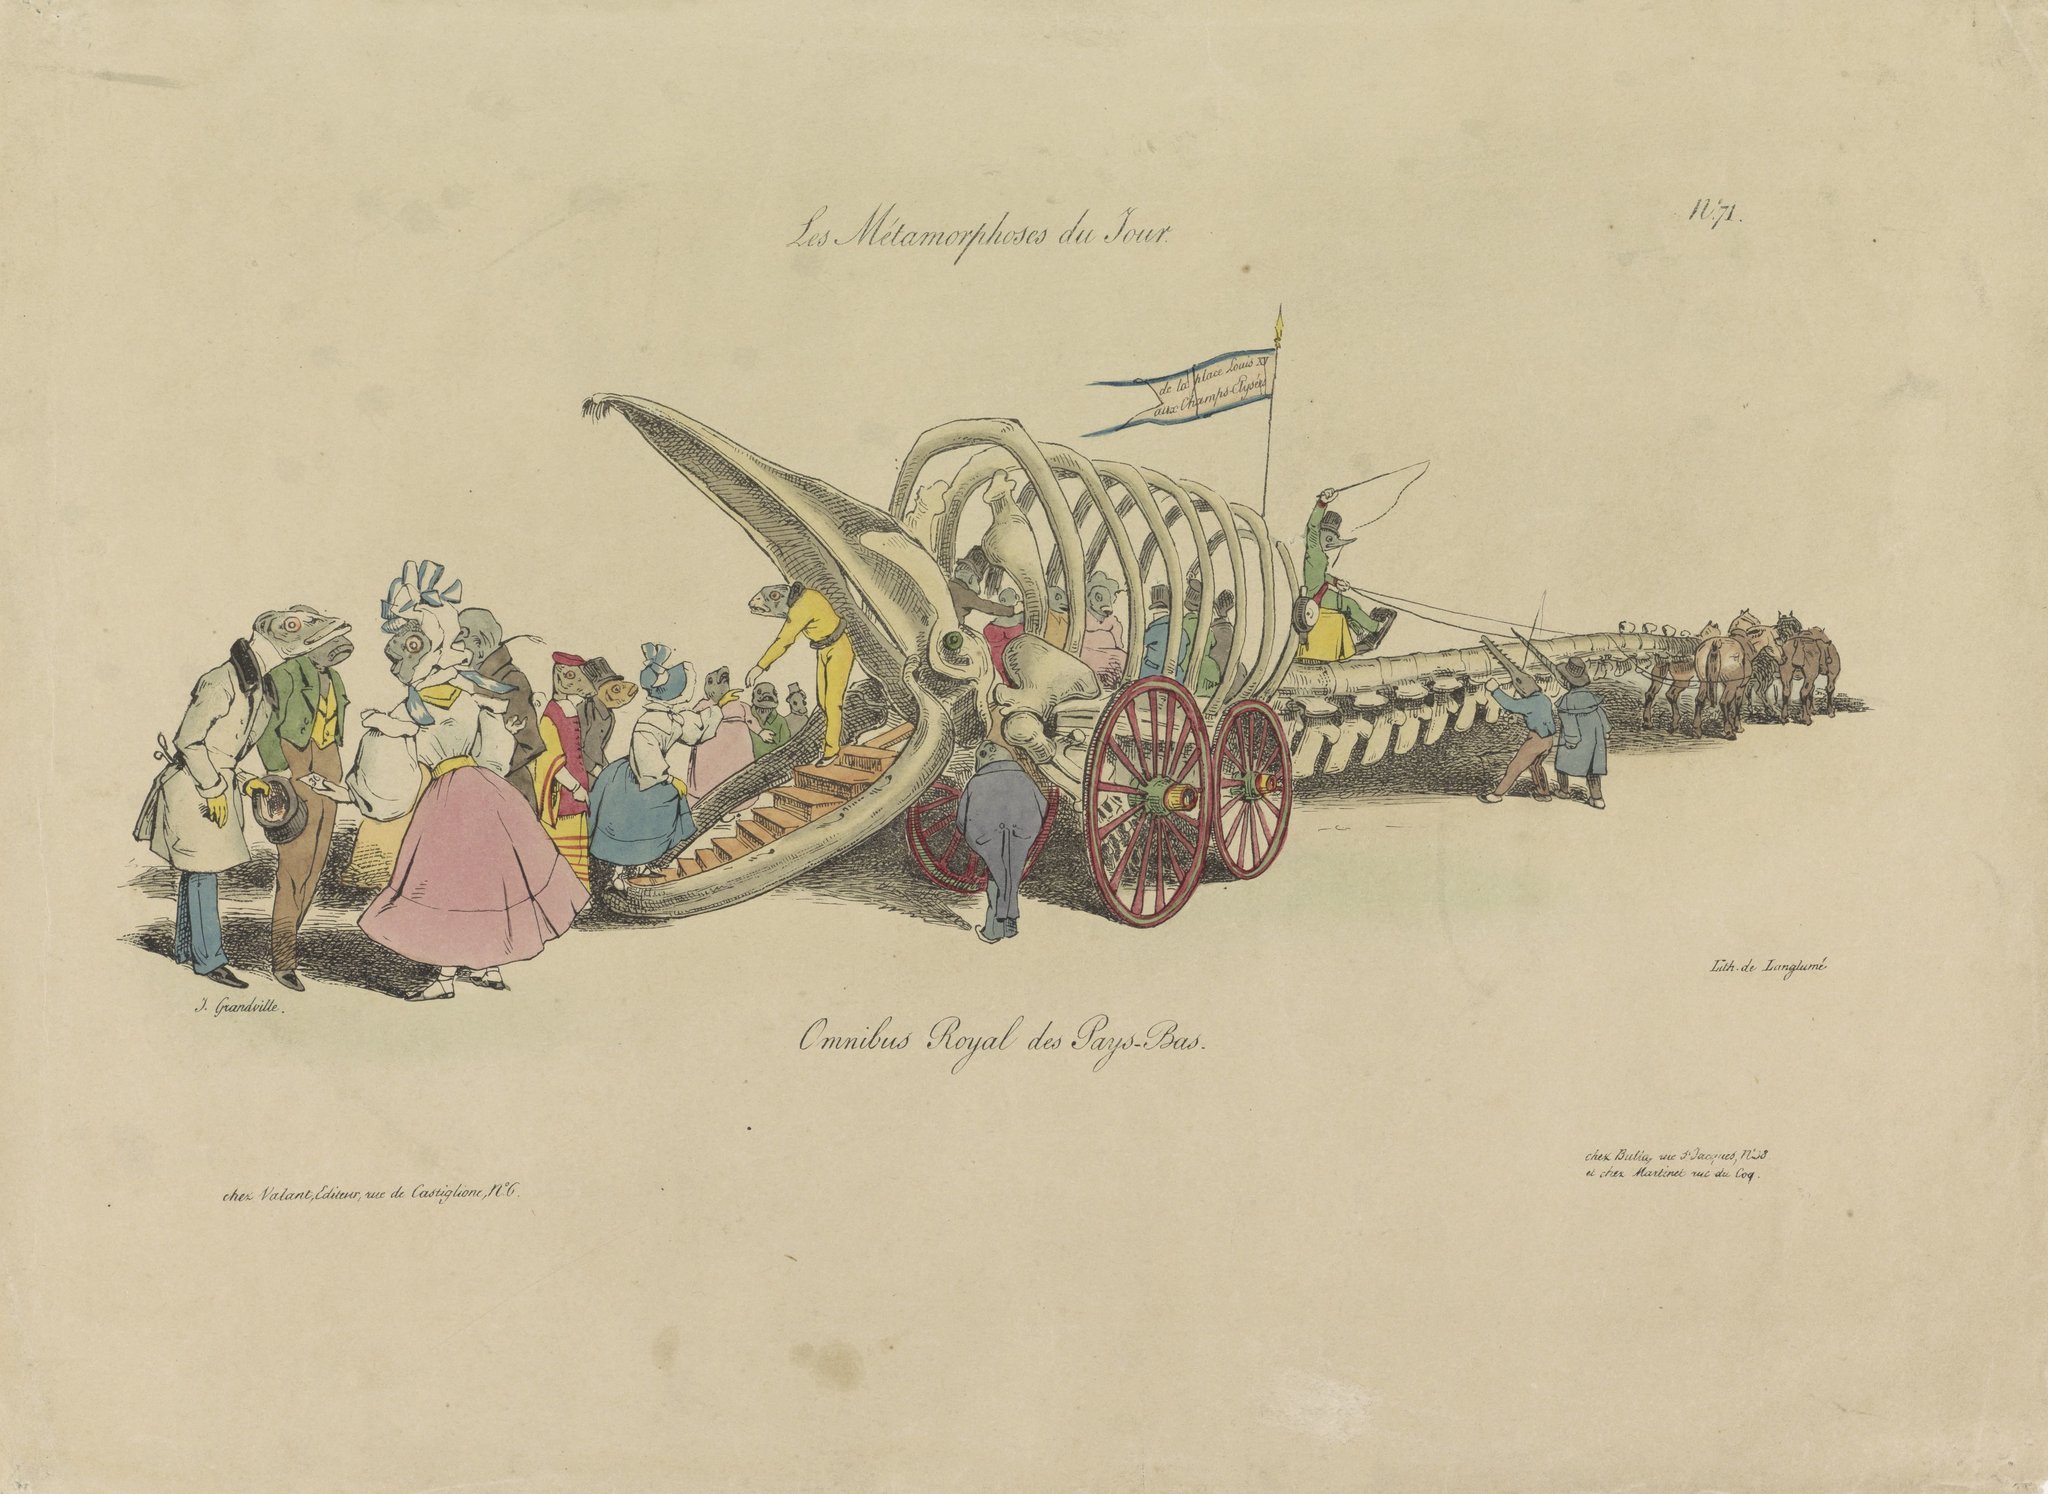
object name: cartoon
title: Walvisgeraamte als de Koninklijke Nederlandse omnibus, 1829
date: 1829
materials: paper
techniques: hand coloring, lithograph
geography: france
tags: herman kessels, four-wheeled vehicle drawn by more than three animals (+ zoological aspects of animals in traffic and transport), animals acting as human beings, swimming mammals: whale (+ dying animal; death of animal; dead animal)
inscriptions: collector's mark: Lugt 2228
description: Spotprent op het rondreizen van Herman Kessels met de te Oostende gestrande walvis, november 1829. Het geraamte van de walvis omgebouwd tot een omnibus, een reiswagen waarin mensen in de gedaante van vissen plaats nemen. Genummerd rechtsboven: No. 71.